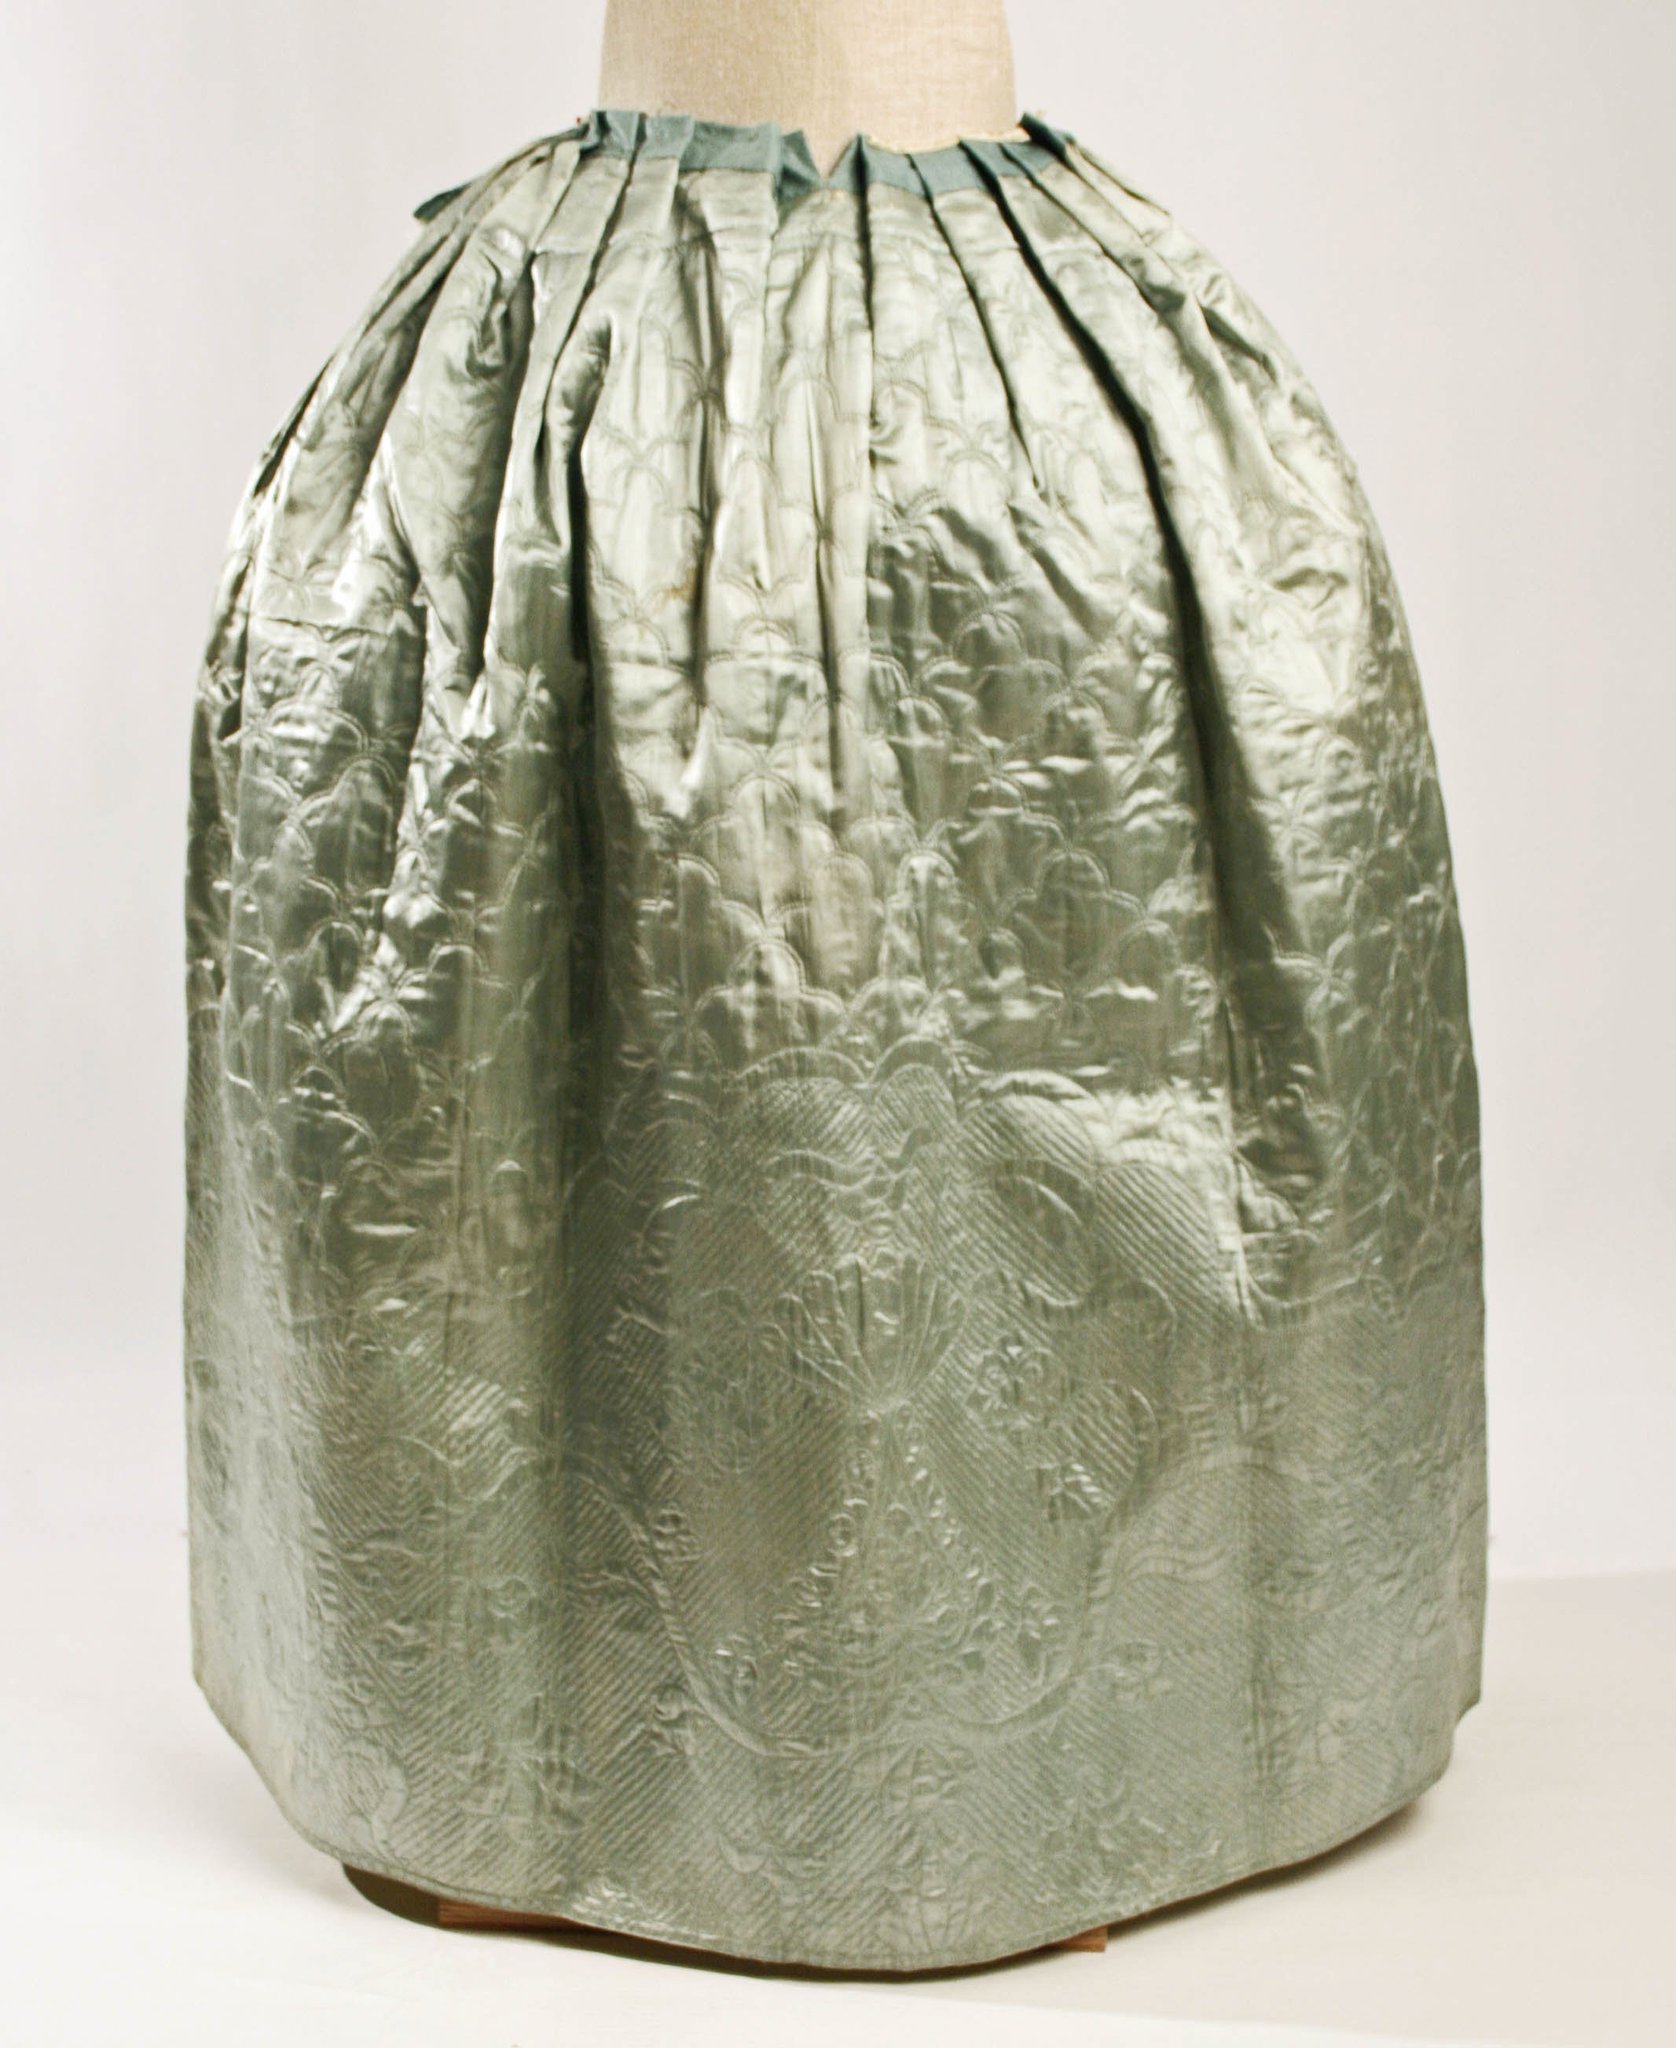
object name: petticoat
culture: american or european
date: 1734-1766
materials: silk